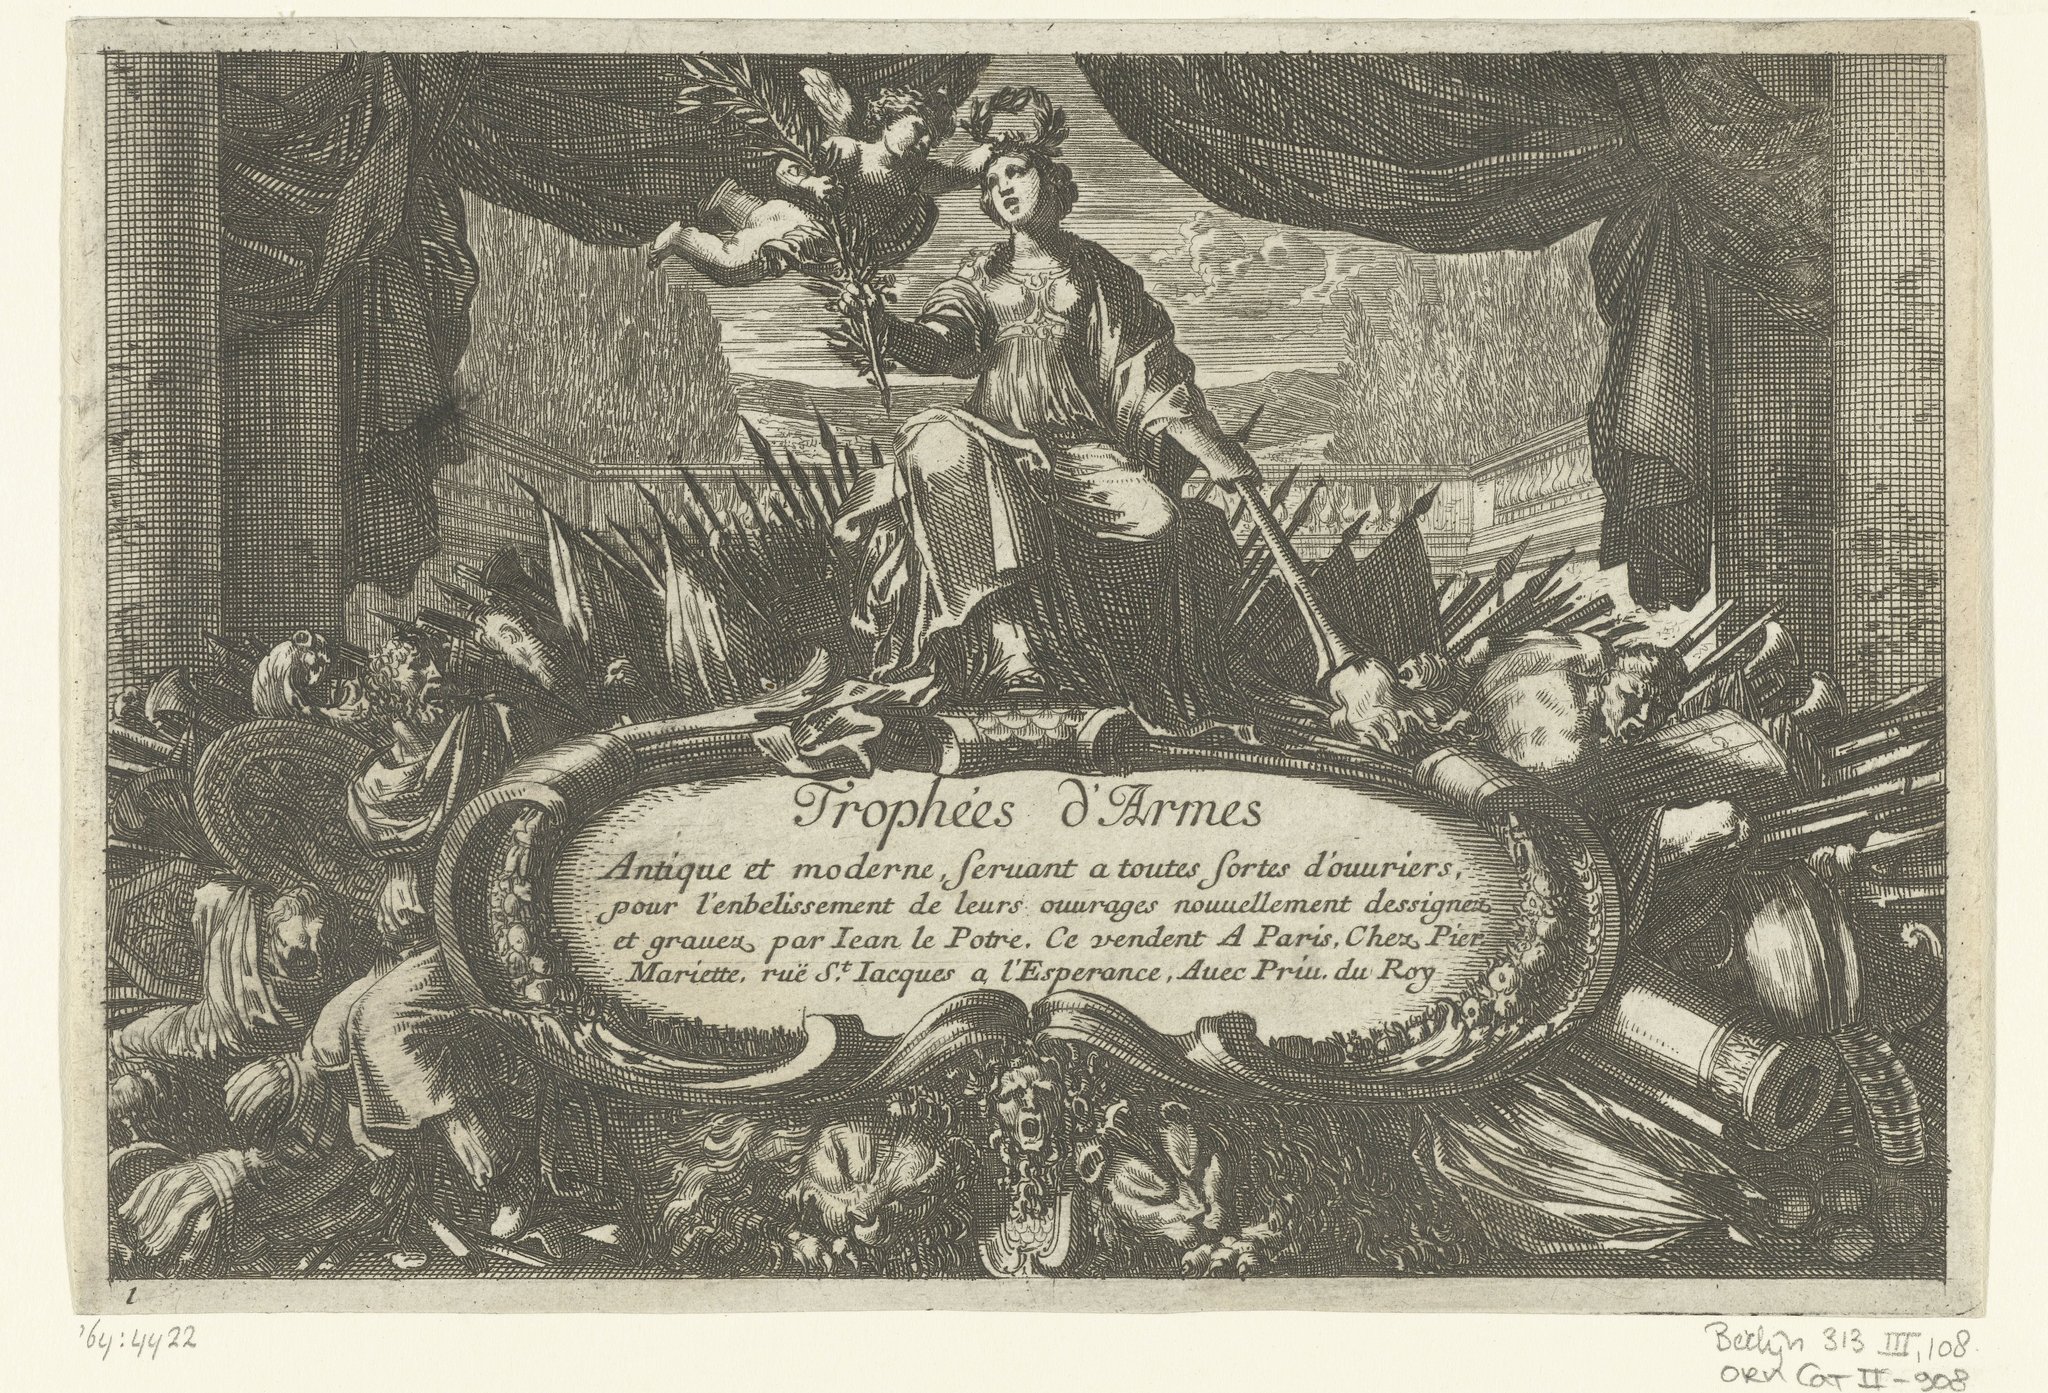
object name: ornament print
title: Trophées d'Armes Antique et moderne, seruant a toutes sortes d'ouuriers, pour l'enbelissement de leurs ouurages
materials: paper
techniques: etching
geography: france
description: De titel staat in een cartouche omringd door wapentrofeeën.